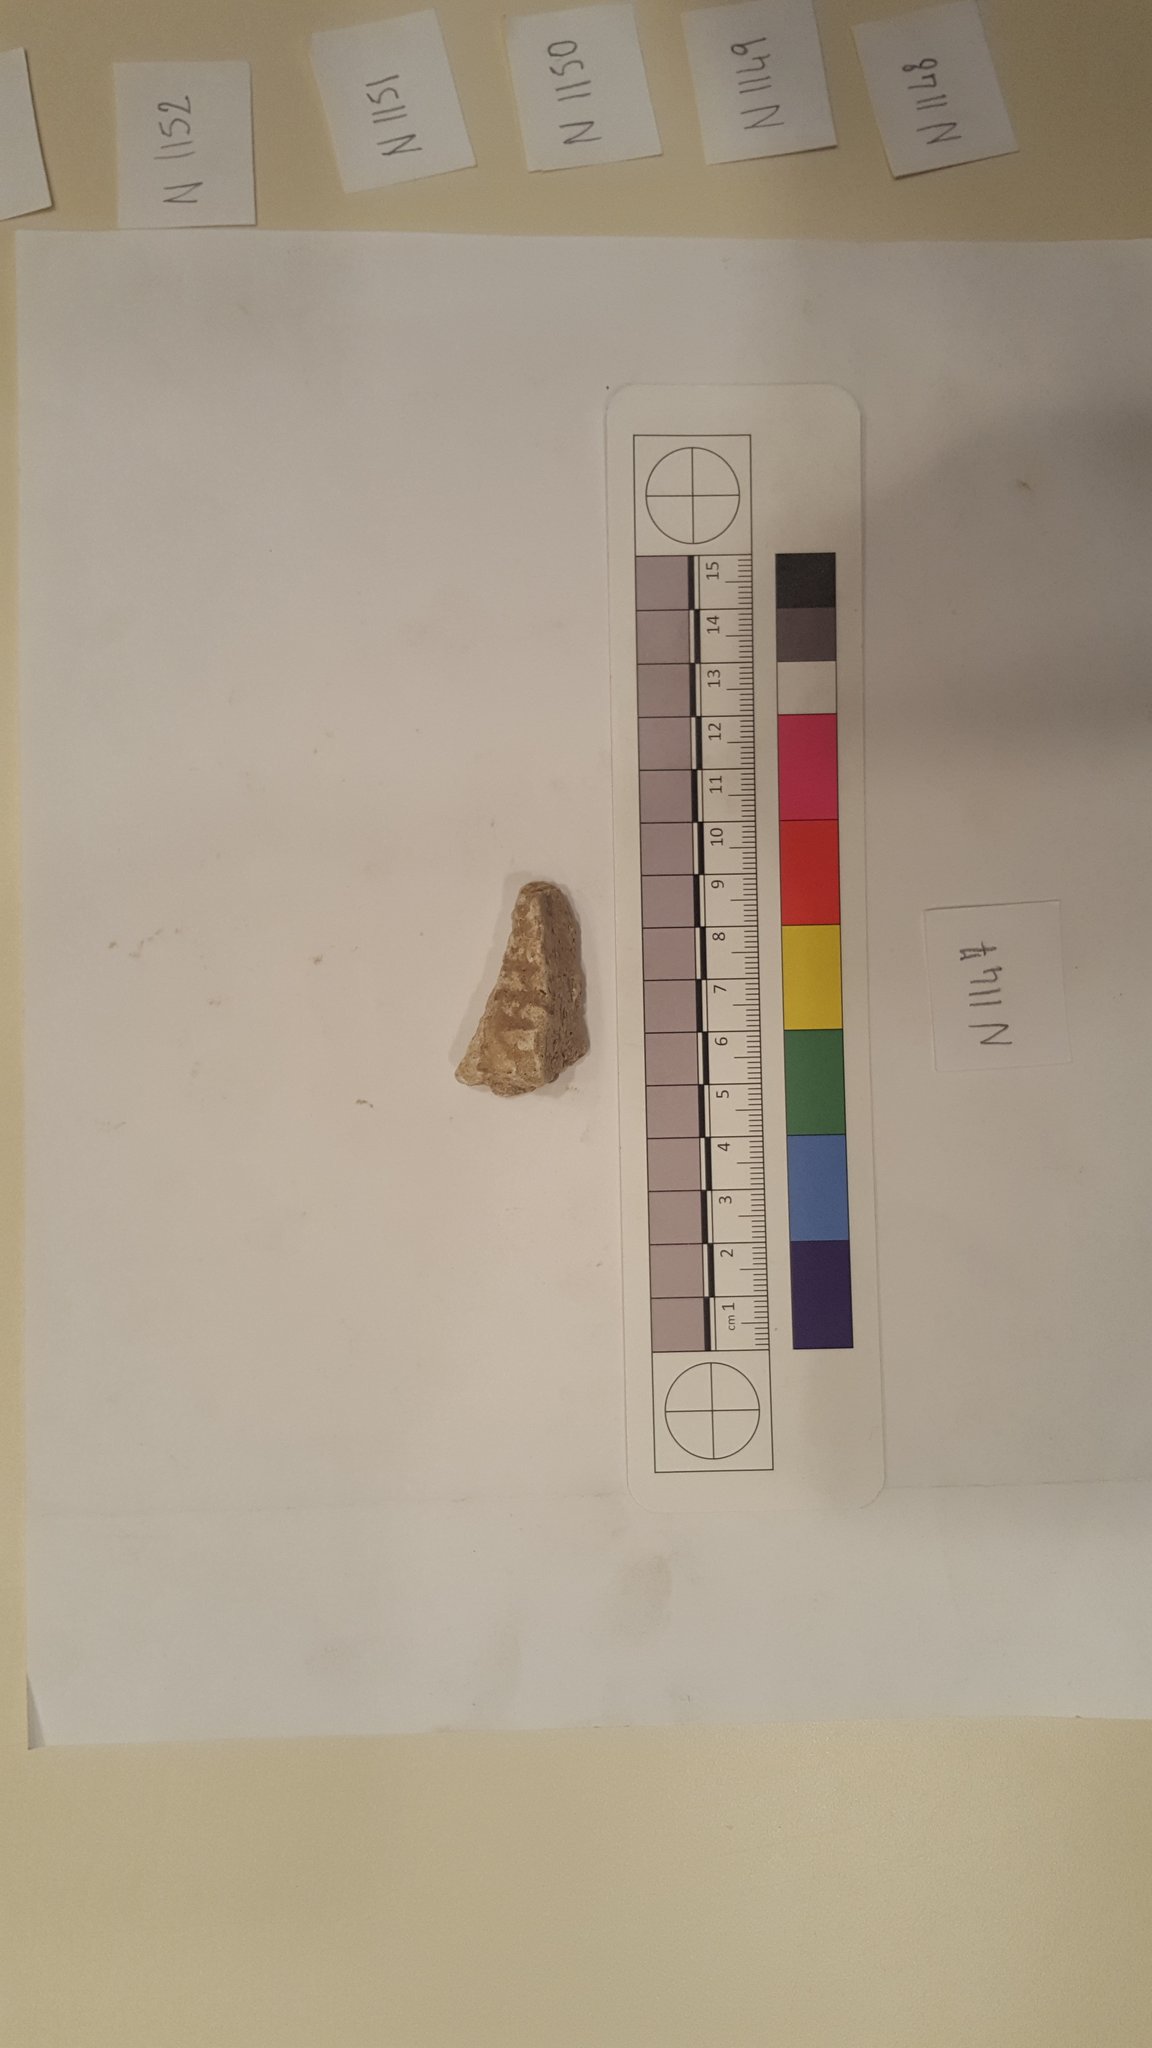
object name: fragment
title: Stucco Fragment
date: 701-1200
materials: plaster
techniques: carving, painting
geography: iran